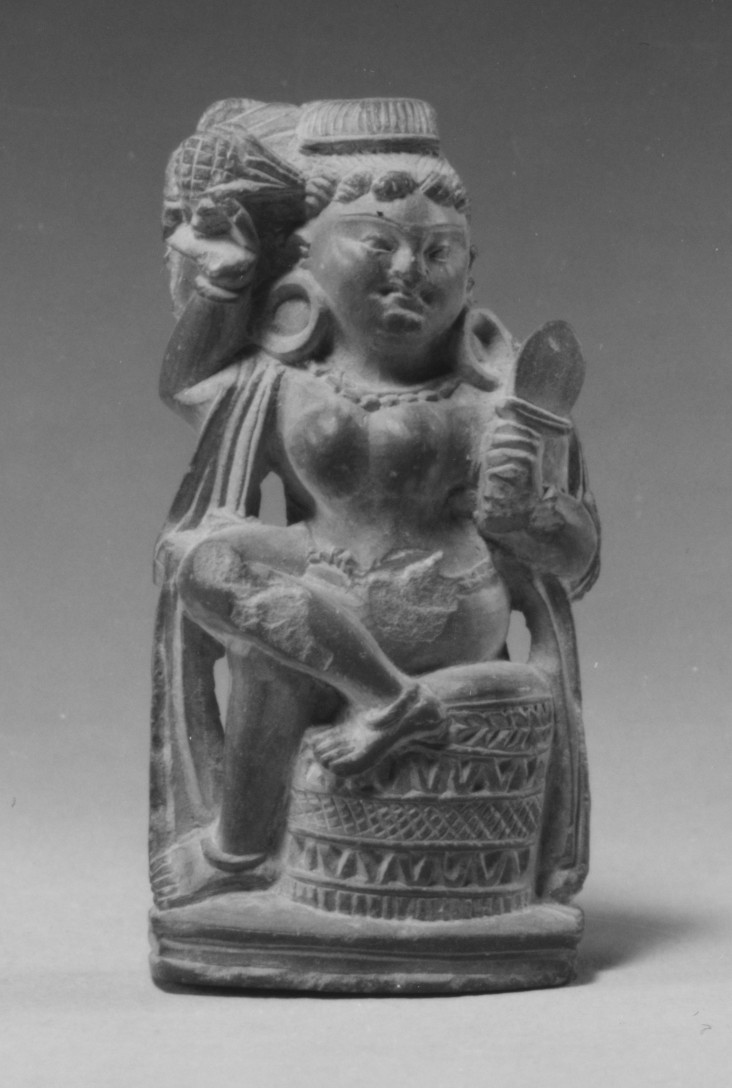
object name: mirror handle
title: Mirror Handle with a Preening Woman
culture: kashmiri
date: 501-800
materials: stone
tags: kashmir,women